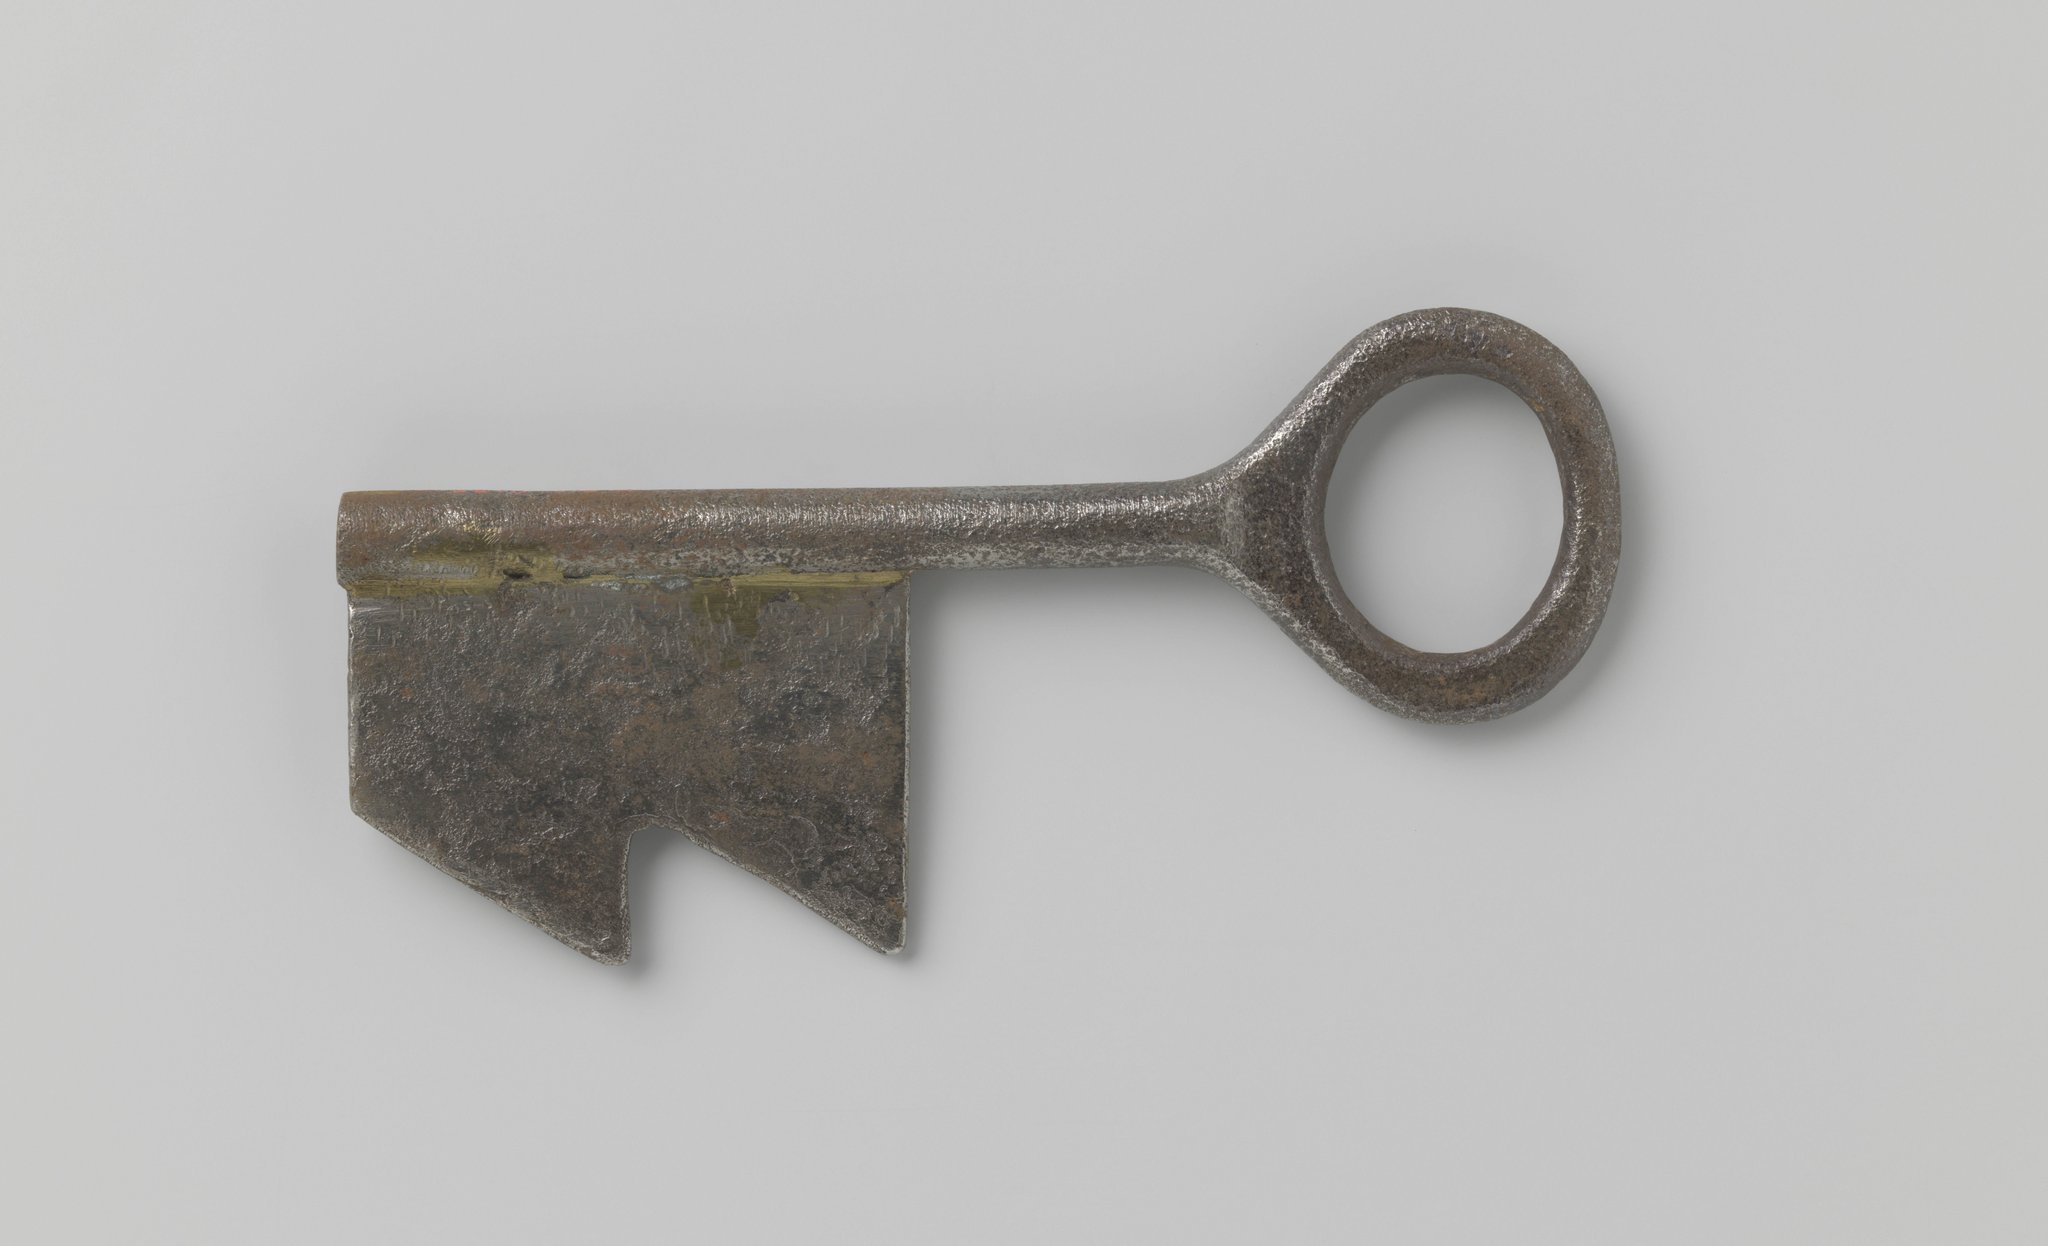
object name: pipe key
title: Pijpsleutel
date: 1400-1950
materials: iron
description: Pijpsleutel met rond oog en grote massieve baard uitlopend in twee gelijkvormige spitse hoeken.